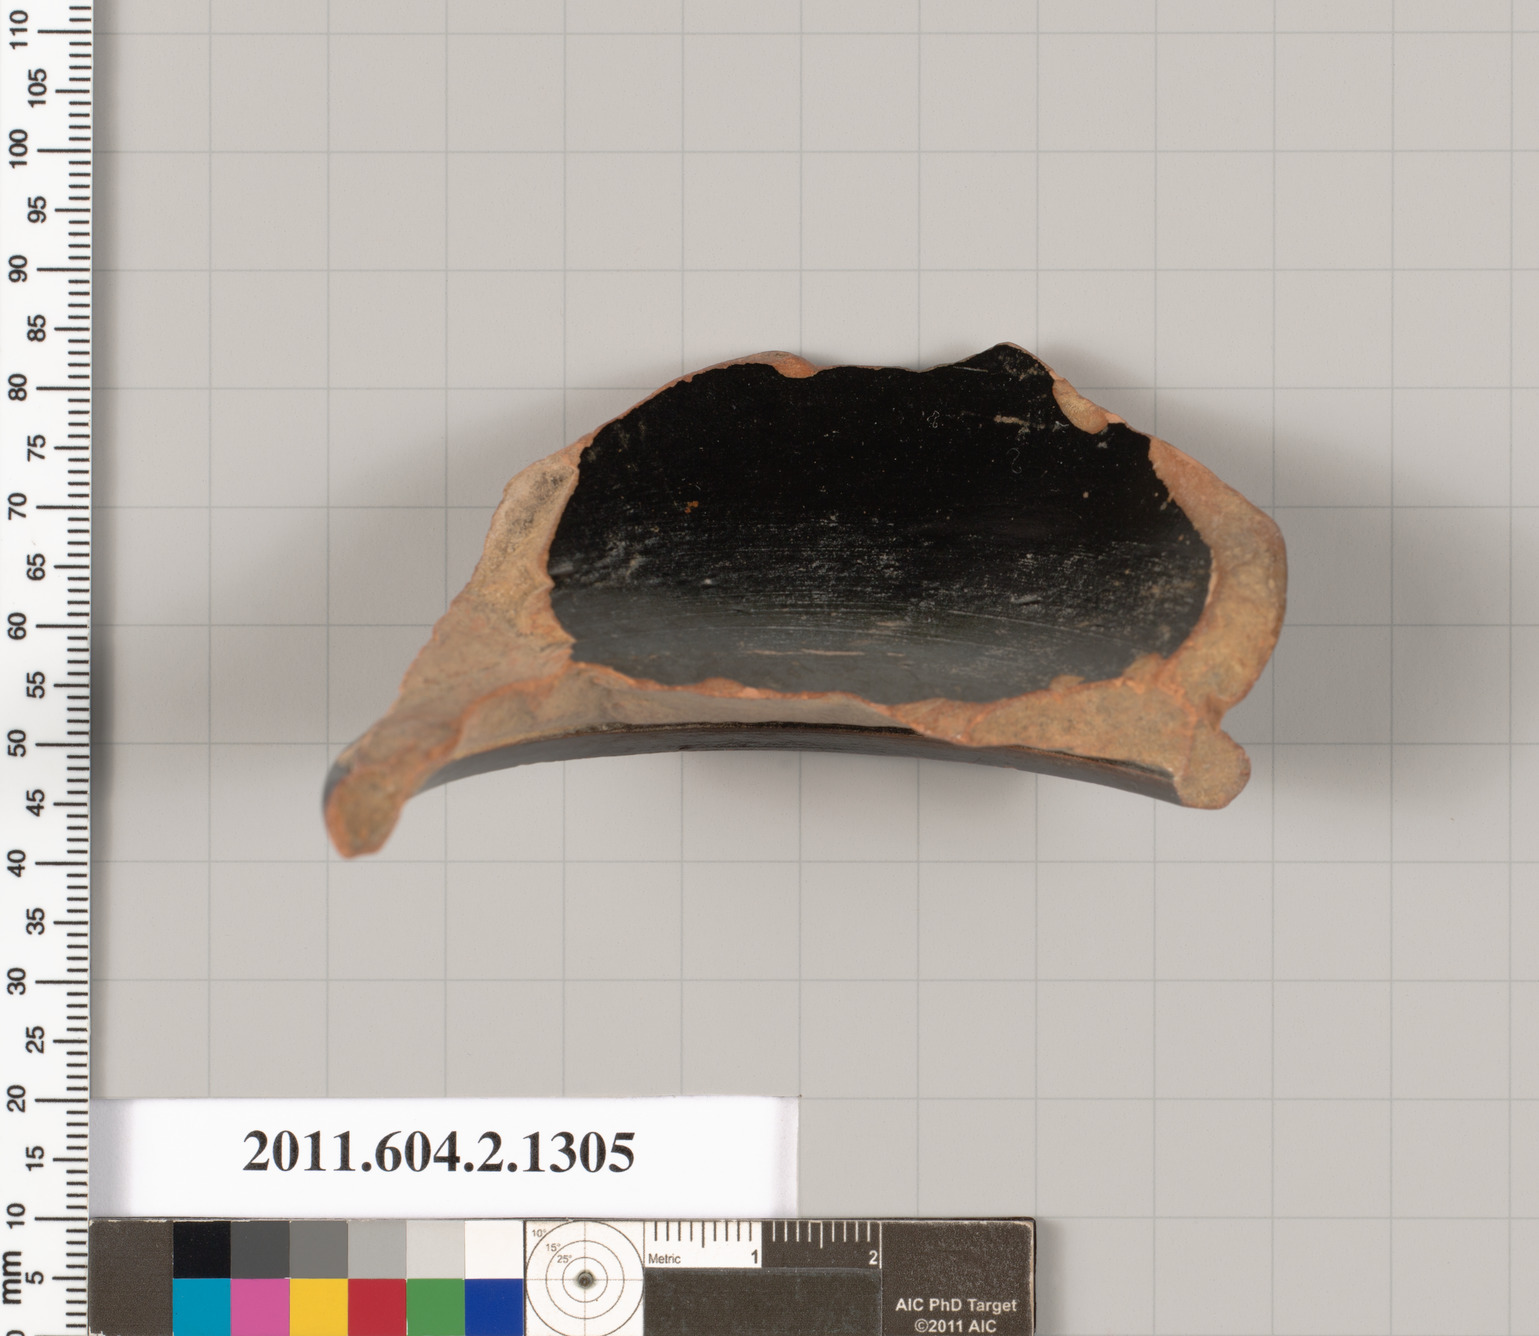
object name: skyphos fragment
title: Terracotta fragment of a skyphos (deep drinking cup)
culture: greek, attic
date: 500-451 BCE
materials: terracotta